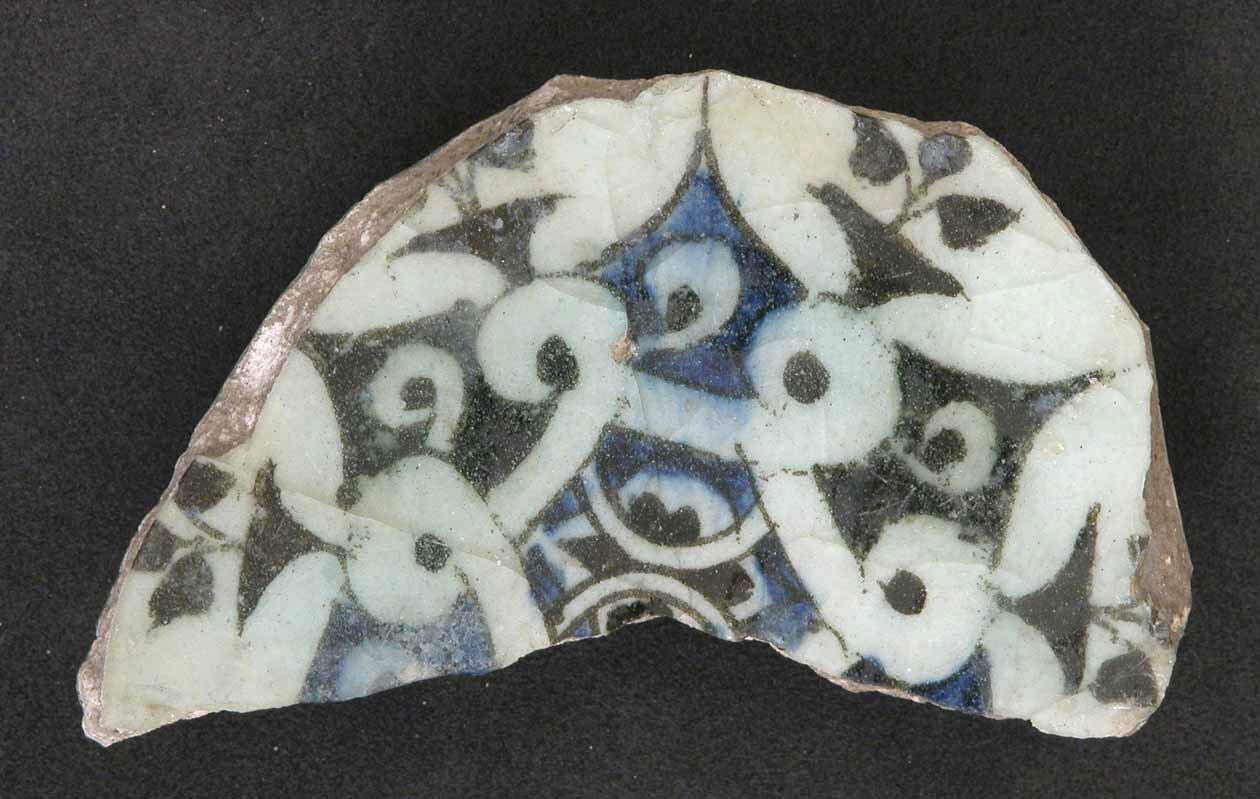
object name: ceramic fragment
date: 1301-1400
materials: stonepaste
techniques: painting, underglaze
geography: egypt